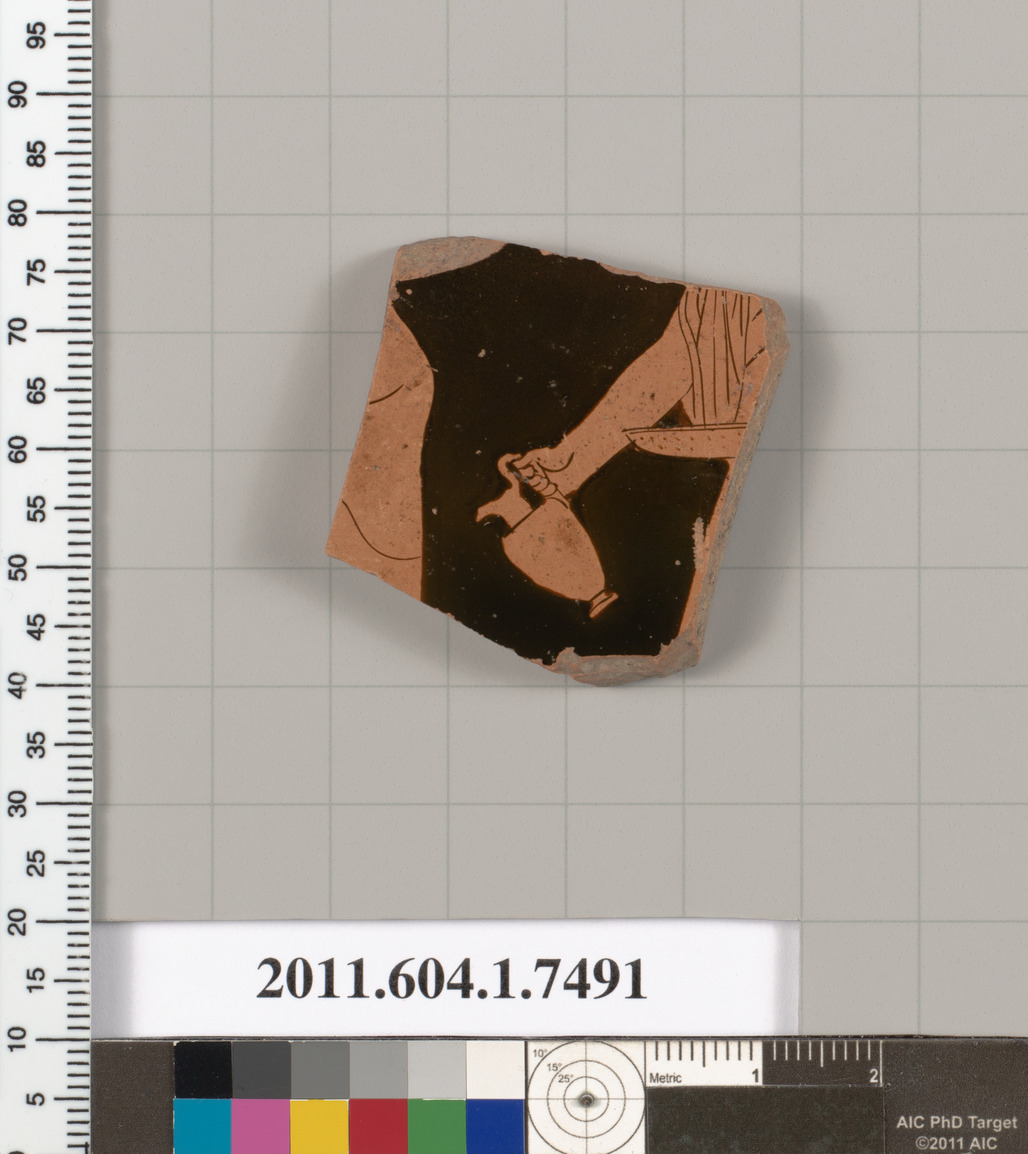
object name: kylix fragment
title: Terracotta fragment of a kylix (drinking cup)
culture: greek, attic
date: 460-450 BCE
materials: terracotta